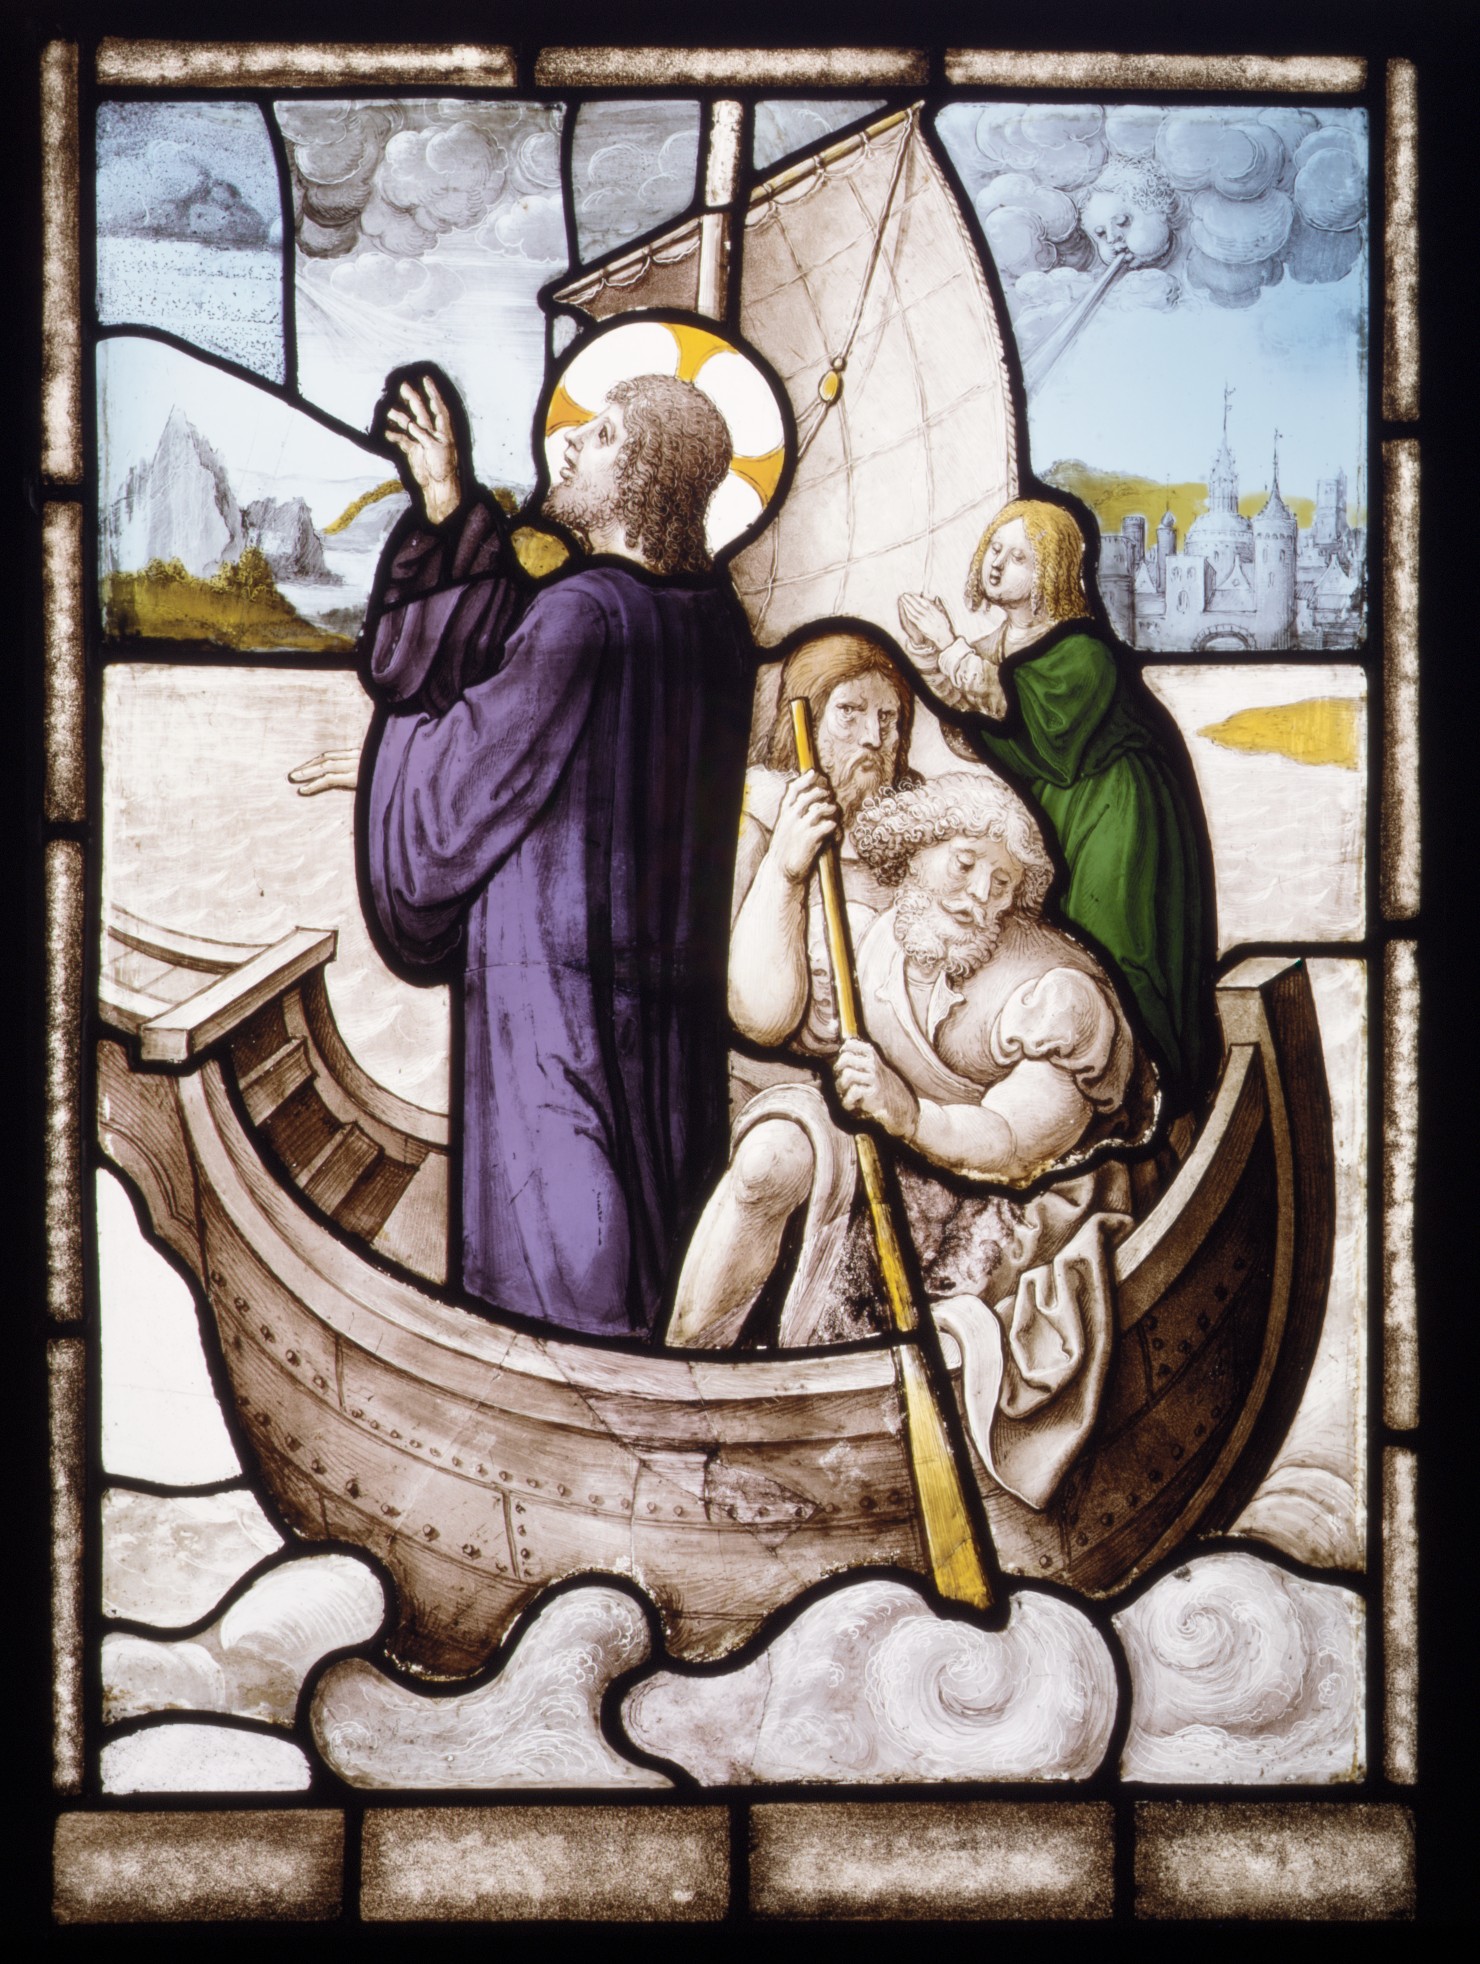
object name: panel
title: Christ Stilling the Tempest (one of a set of 12 scenes from The Life of Christ)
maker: jan rombouts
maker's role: maker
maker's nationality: south netherlandish (duchy of brabant)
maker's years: 1475-1535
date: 1520-1525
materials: glass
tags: christ,boats